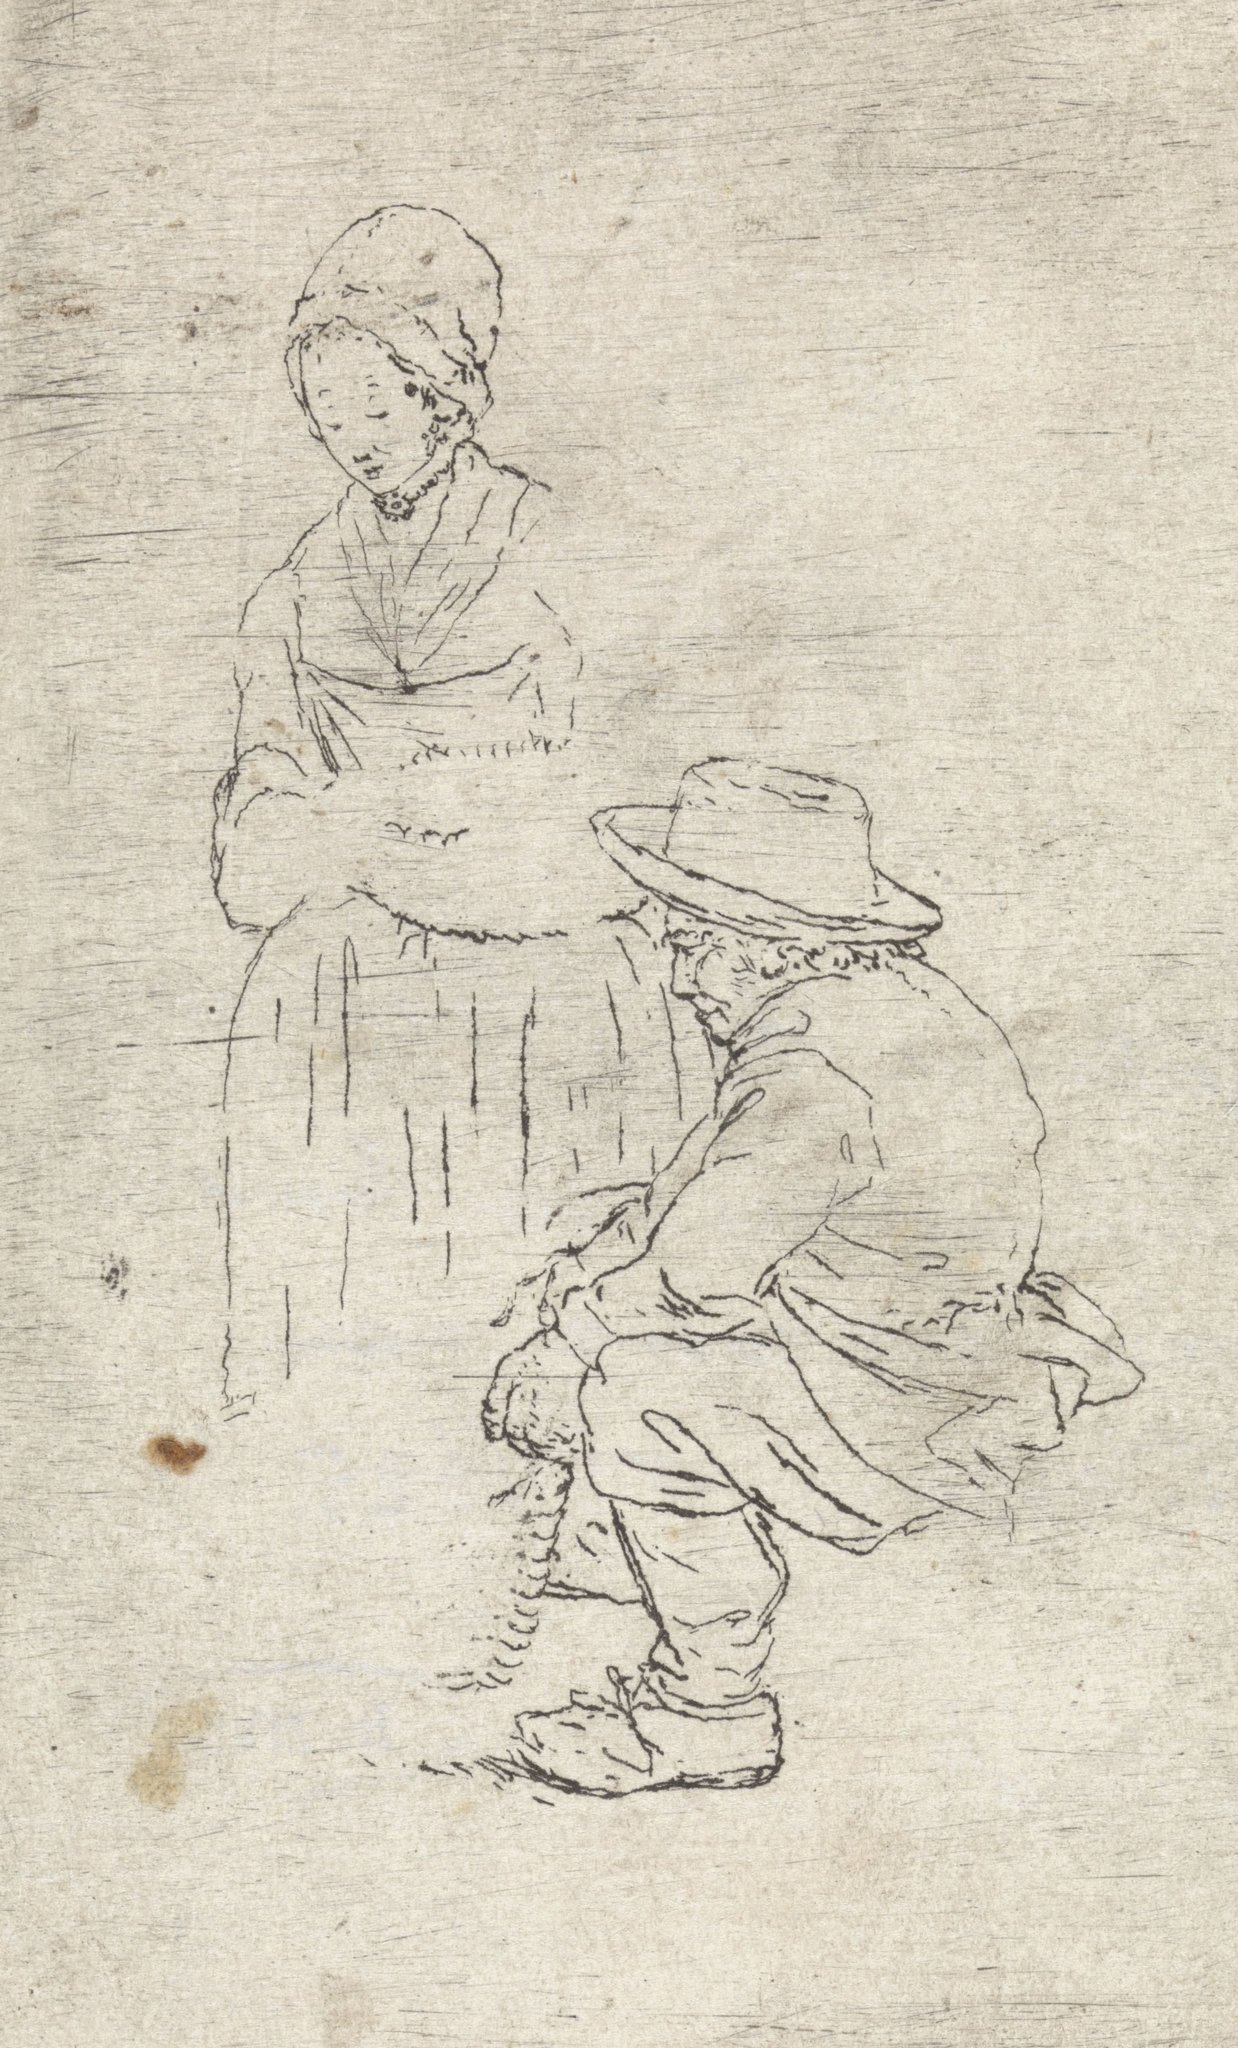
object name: print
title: Boer en boerin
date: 1739-1851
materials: paper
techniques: etching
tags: farmers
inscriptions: collector's mark: Lugt 2228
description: Een zittende man met hoed en klompen, naar links. Naast hem staat een vrouw met gebogen hoofd, ze draagt een kapje en een schort.